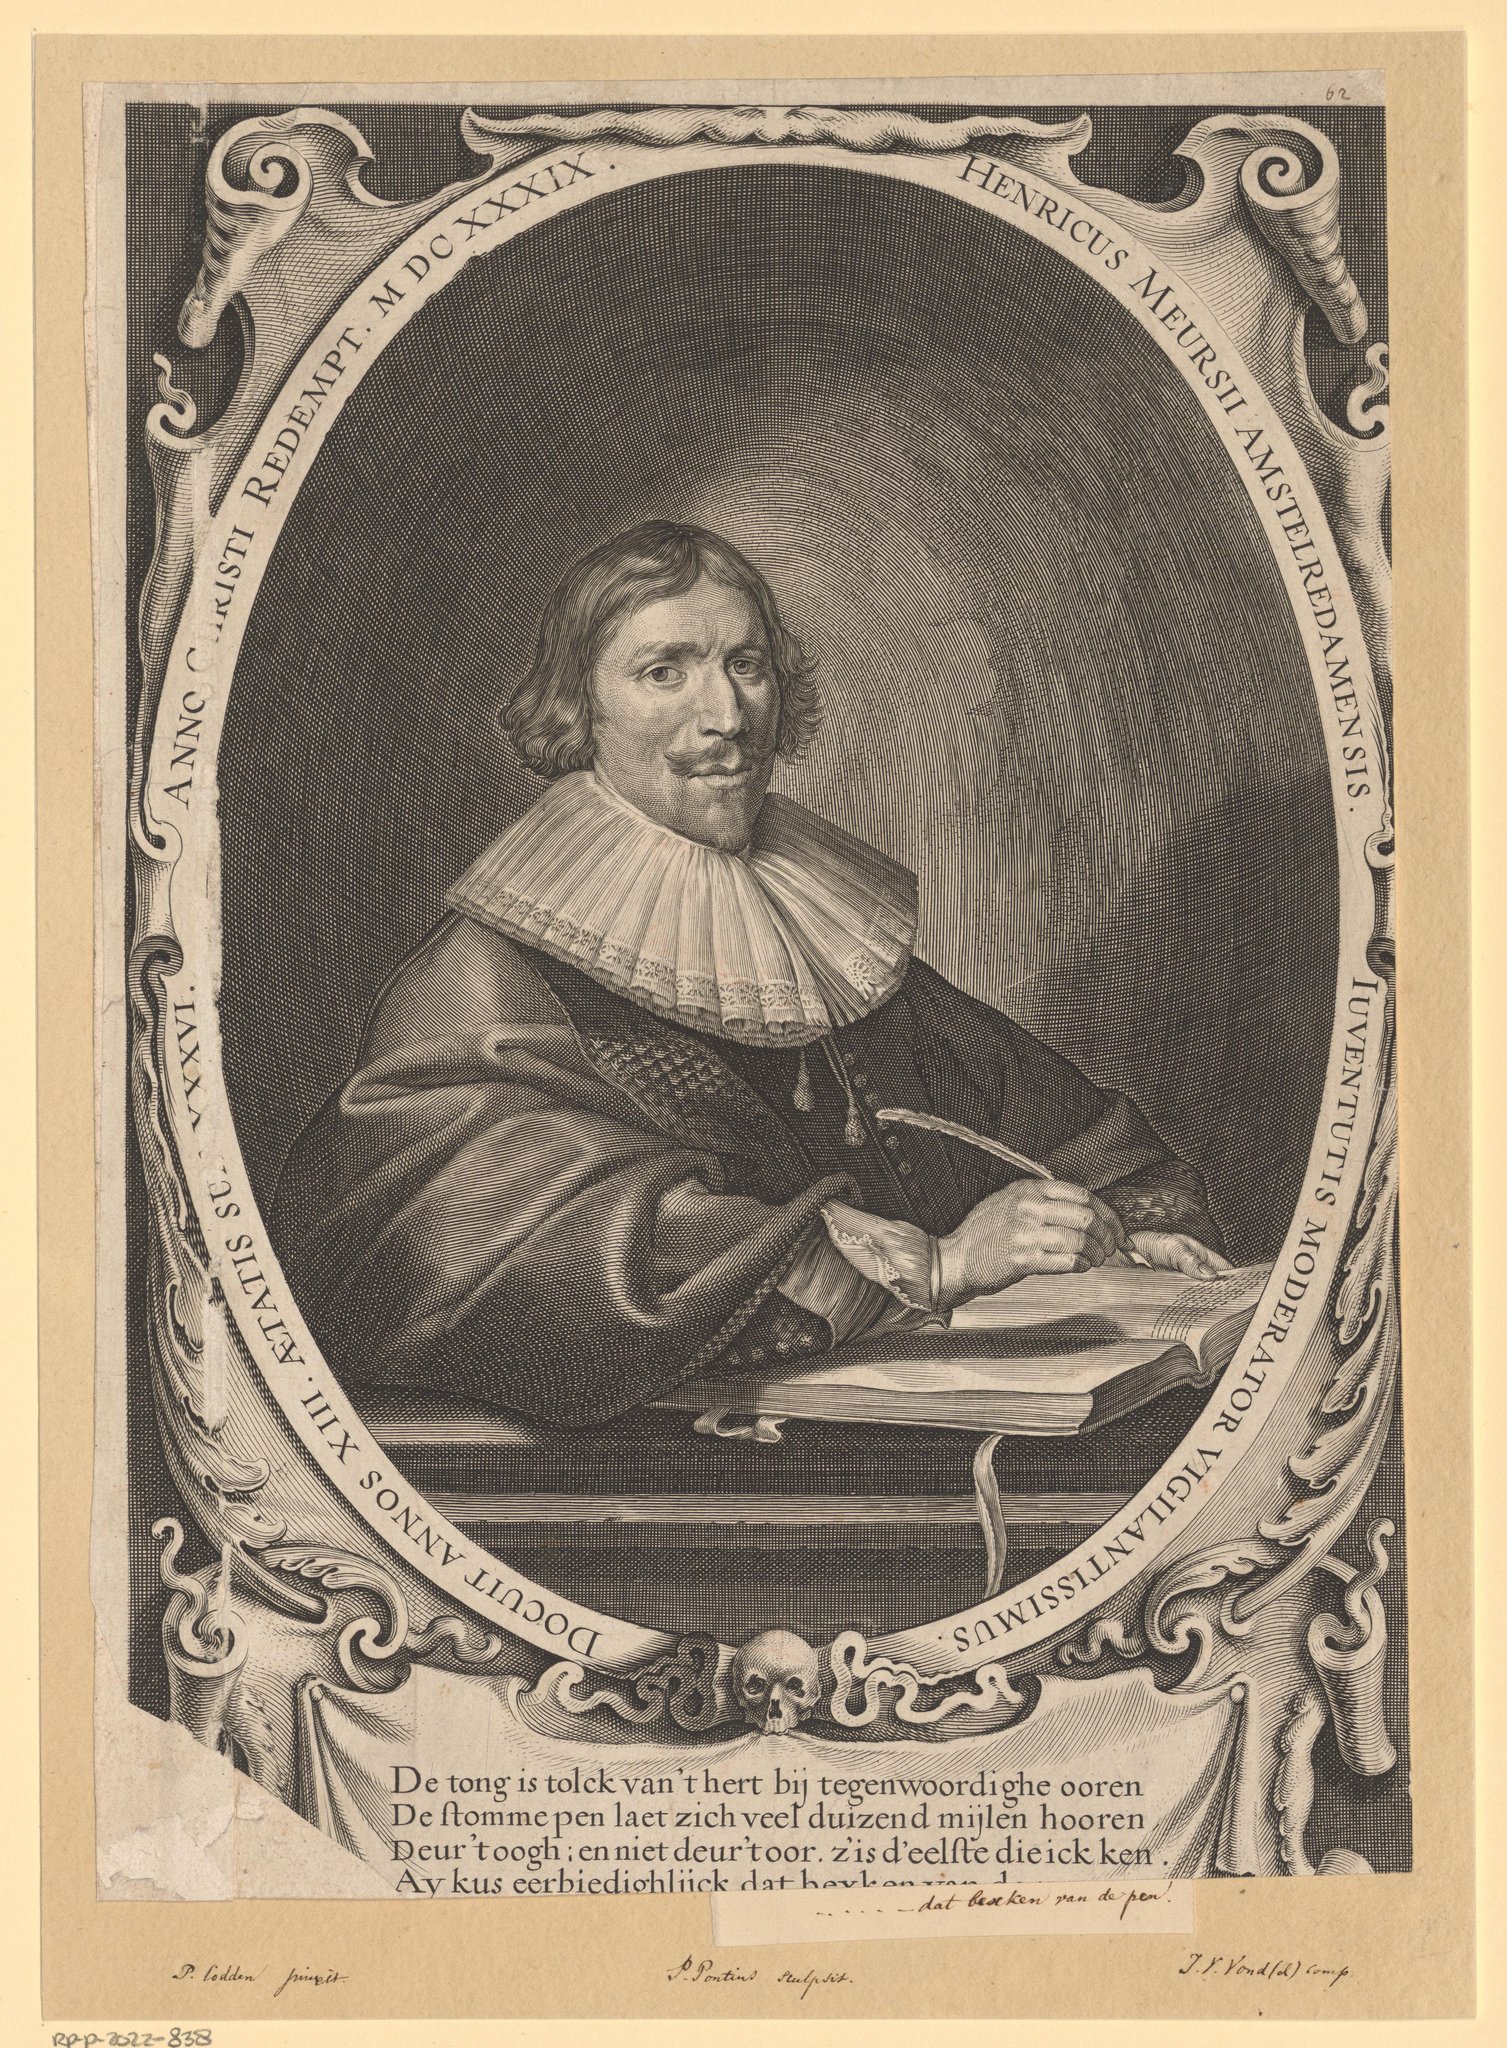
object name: print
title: Henricus MeursII Amsterdamensis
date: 1639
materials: paper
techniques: engraving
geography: antwerp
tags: amsterdam, historical persons, pen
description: Met vierregelig onderschrift in het Nederlands.